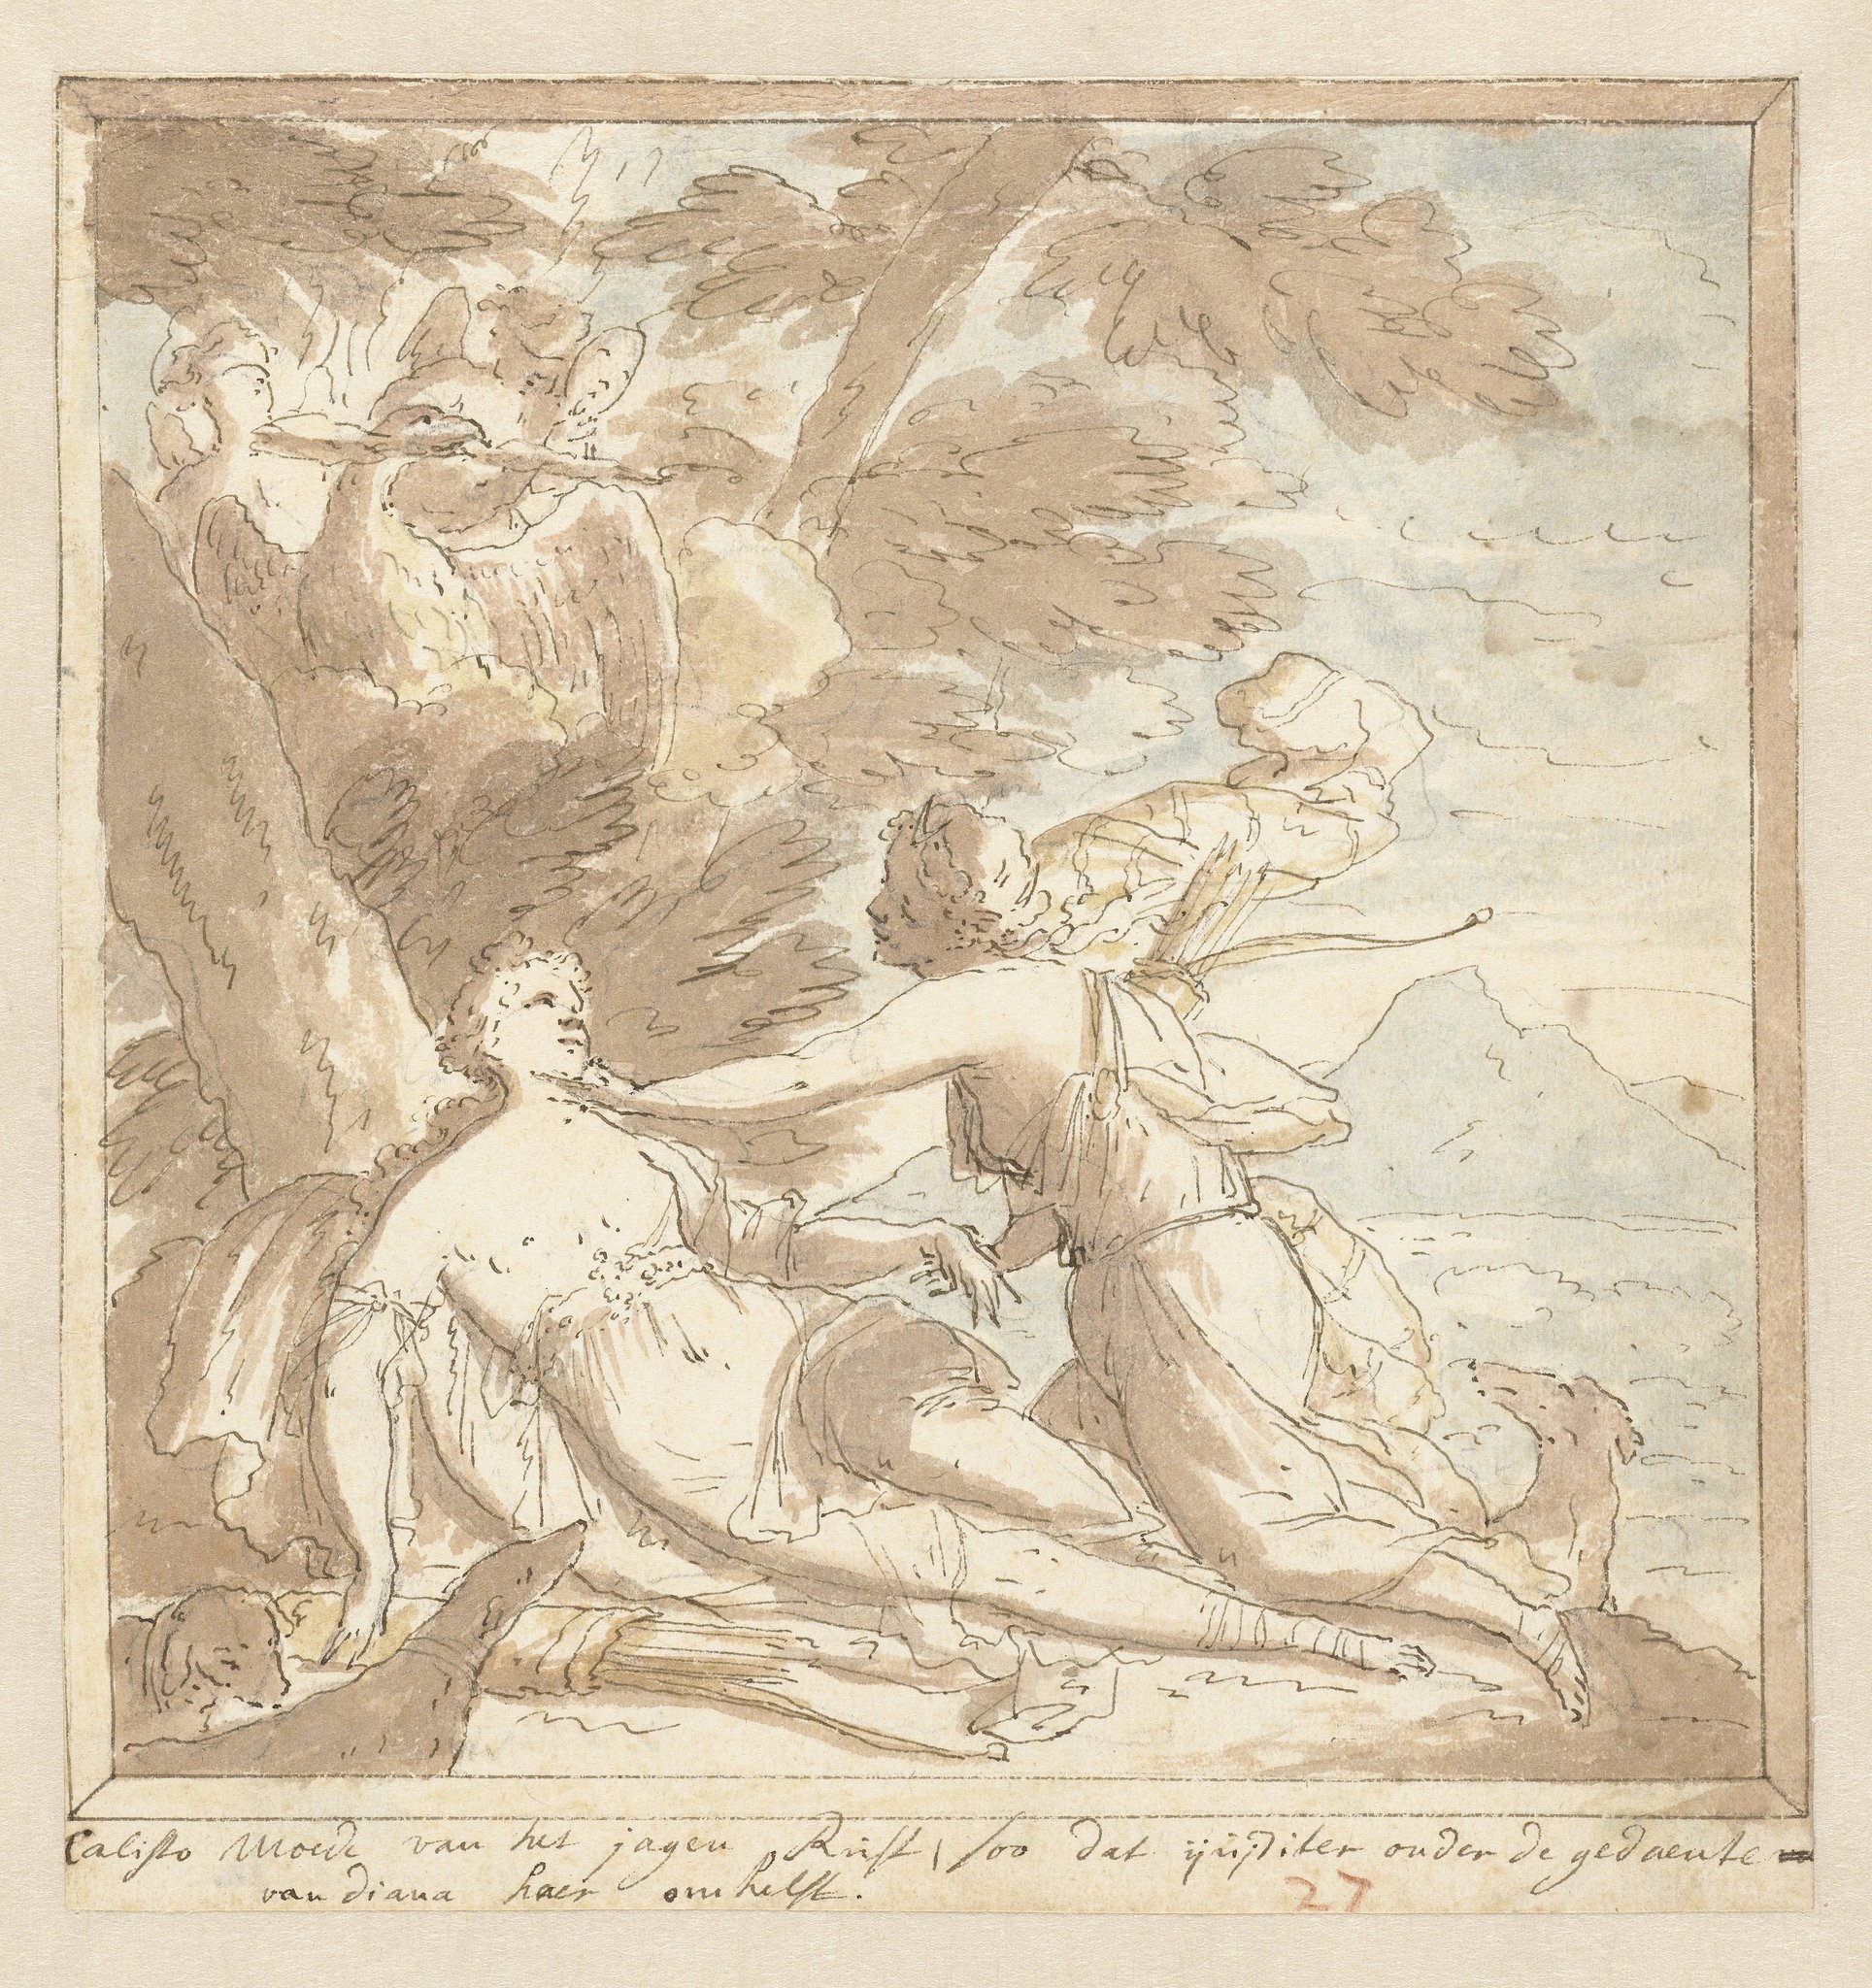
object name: drawing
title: Jupiter en Callisto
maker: mattheus terwesten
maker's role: draughtsman, painter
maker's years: 1670-1757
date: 1680-1757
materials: graphite, ink, paper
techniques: brush, pen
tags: jupiter, in the guise of diana, and callisto, homosexual love - cc - homosexual love between women: lesbianism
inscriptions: : ‘Calisto moede van het jagen rust, soo dat jupiter onder de gedaante van diana haer omhelst.’